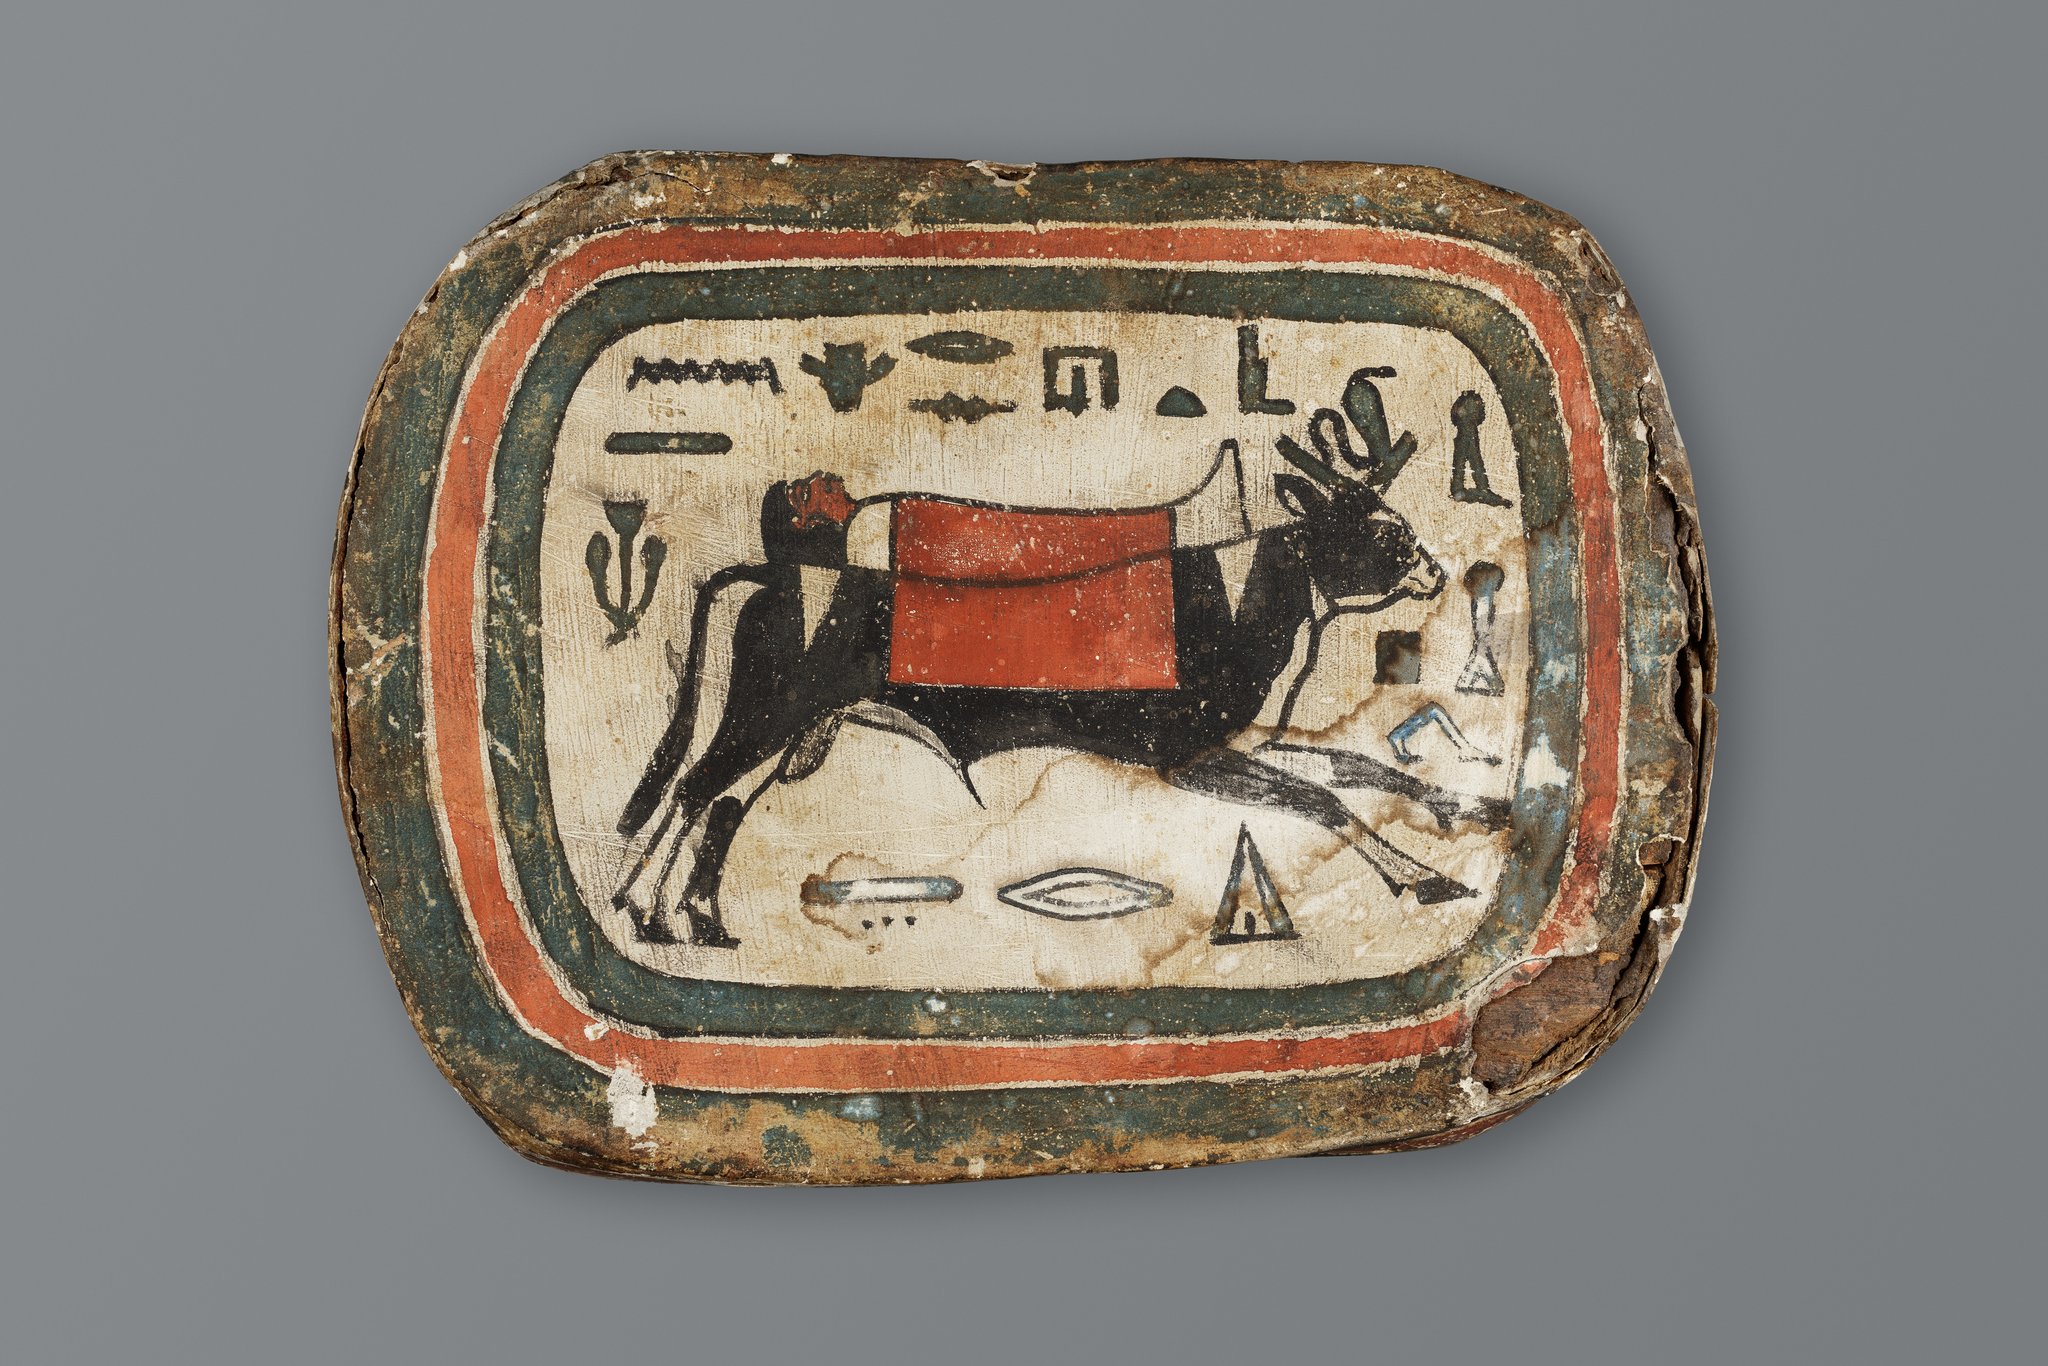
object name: coffin foot, bull, heribsenes, heresenes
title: Footboard from the cartonnage case of Heresenes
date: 750-700 BCE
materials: paint, paste, wood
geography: egypt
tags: bulls